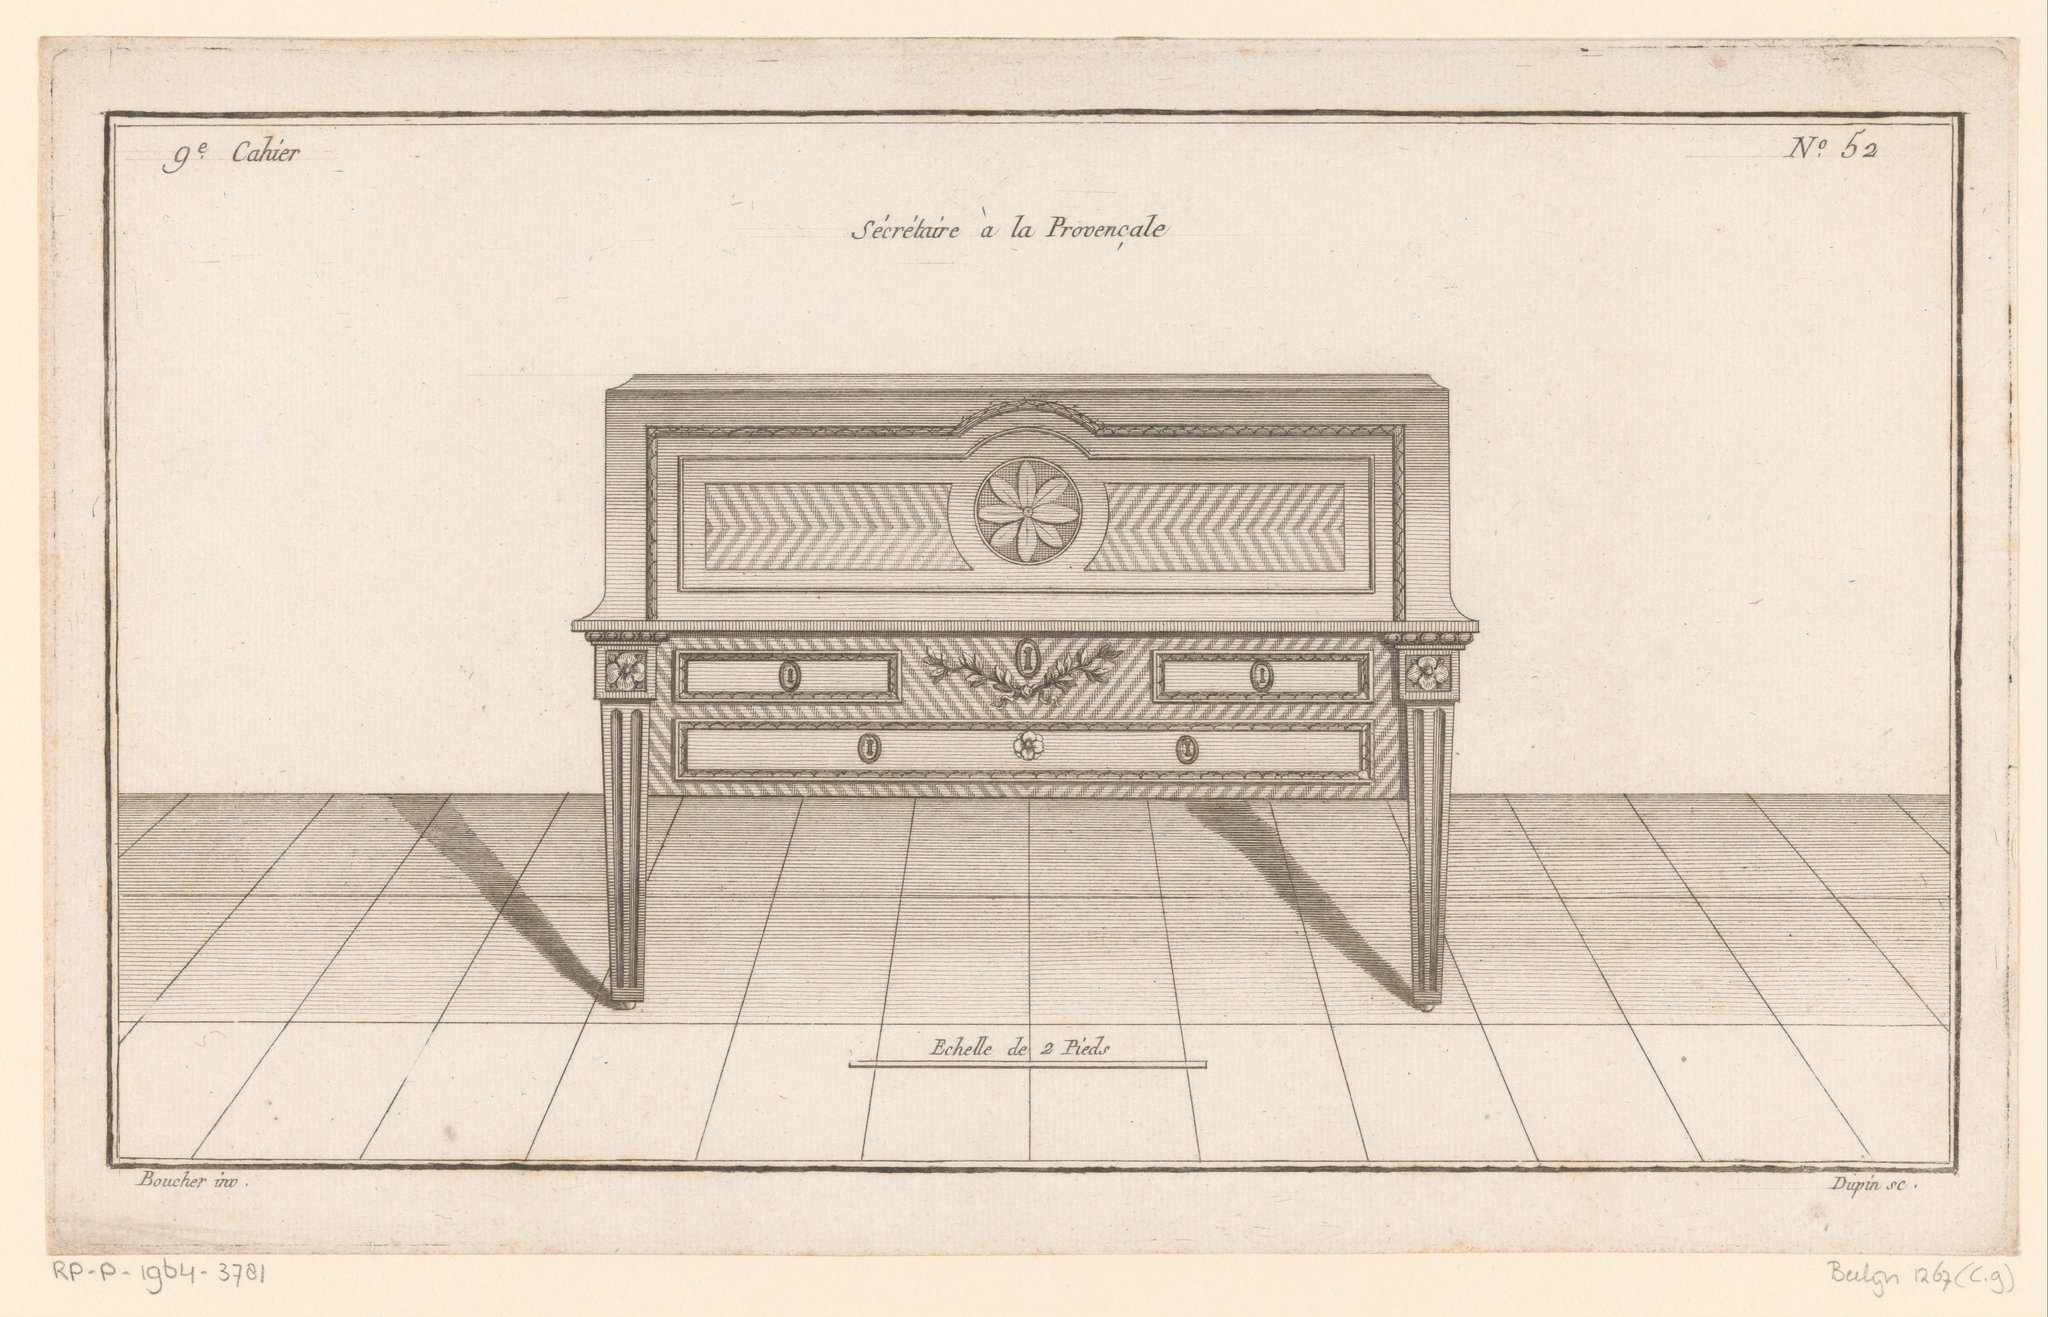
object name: print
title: 9e Cahier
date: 1772-1779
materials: paper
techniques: engraving, etching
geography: paris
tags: writing-table, writing-desk, ornament derived from plant forms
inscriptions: collector's mark: Lugt 2228, collector's mark: Lugt 2760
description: Een geornamenteerde secretaire met bloemmotieven en ranken. Prentnummer 52.